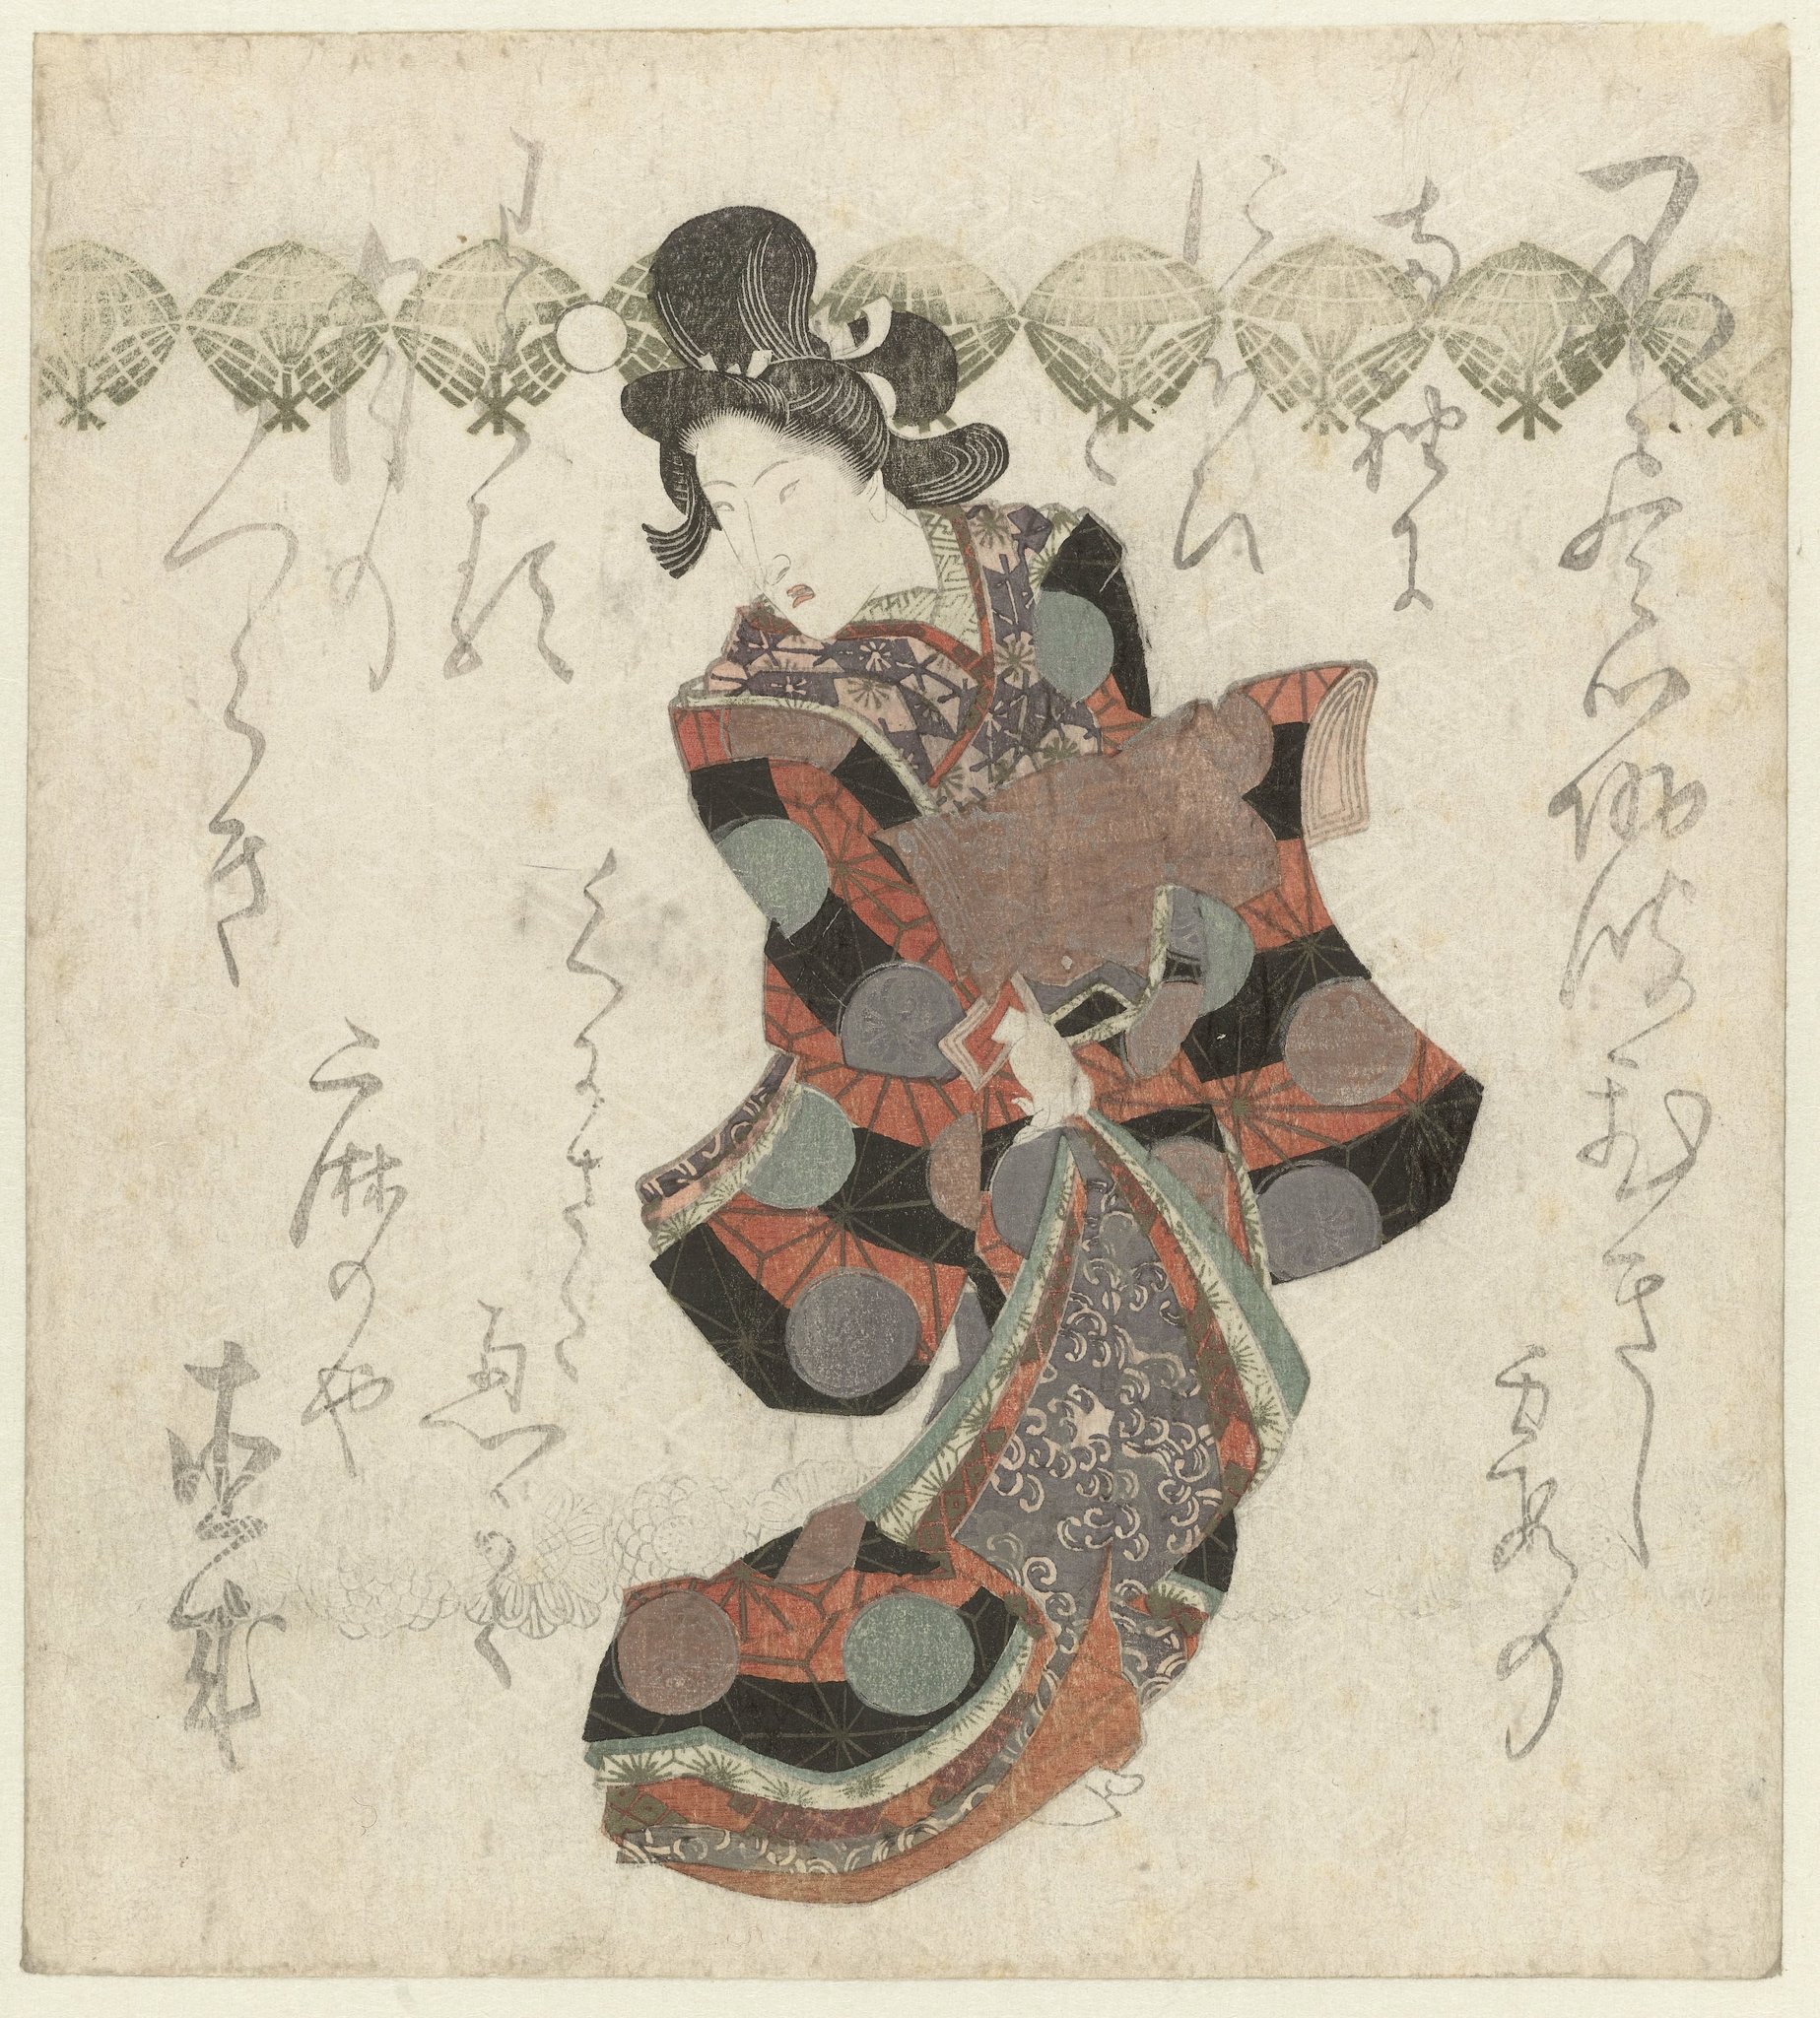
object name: surimono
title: Paraderende courisane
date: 1825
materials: paper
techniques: blind stamped, woodcut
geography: japan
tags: courtesan, hetaera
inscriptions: collector's mark, verso, stamped: Lugt 2228, collector's mark, verso, stamped: Lugt 2973, collector's mark, passe-partout, bottom left, printed: JABdH with a rooster.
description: Een surimono is een luxe uitgevoerde prent waarop beeld met één of meerdere gedichten gecombineerd is. Bij het drukken van een surimono werd vaak gebruik gemaakt van dikker papier, blinddruk en metaal pigmenten, zoals koper- en zilverpoeder. De prenten werden vaak in opdracht van dichters gemaakt en als exclusief geschenk aan vrienden en relaties gegeven.